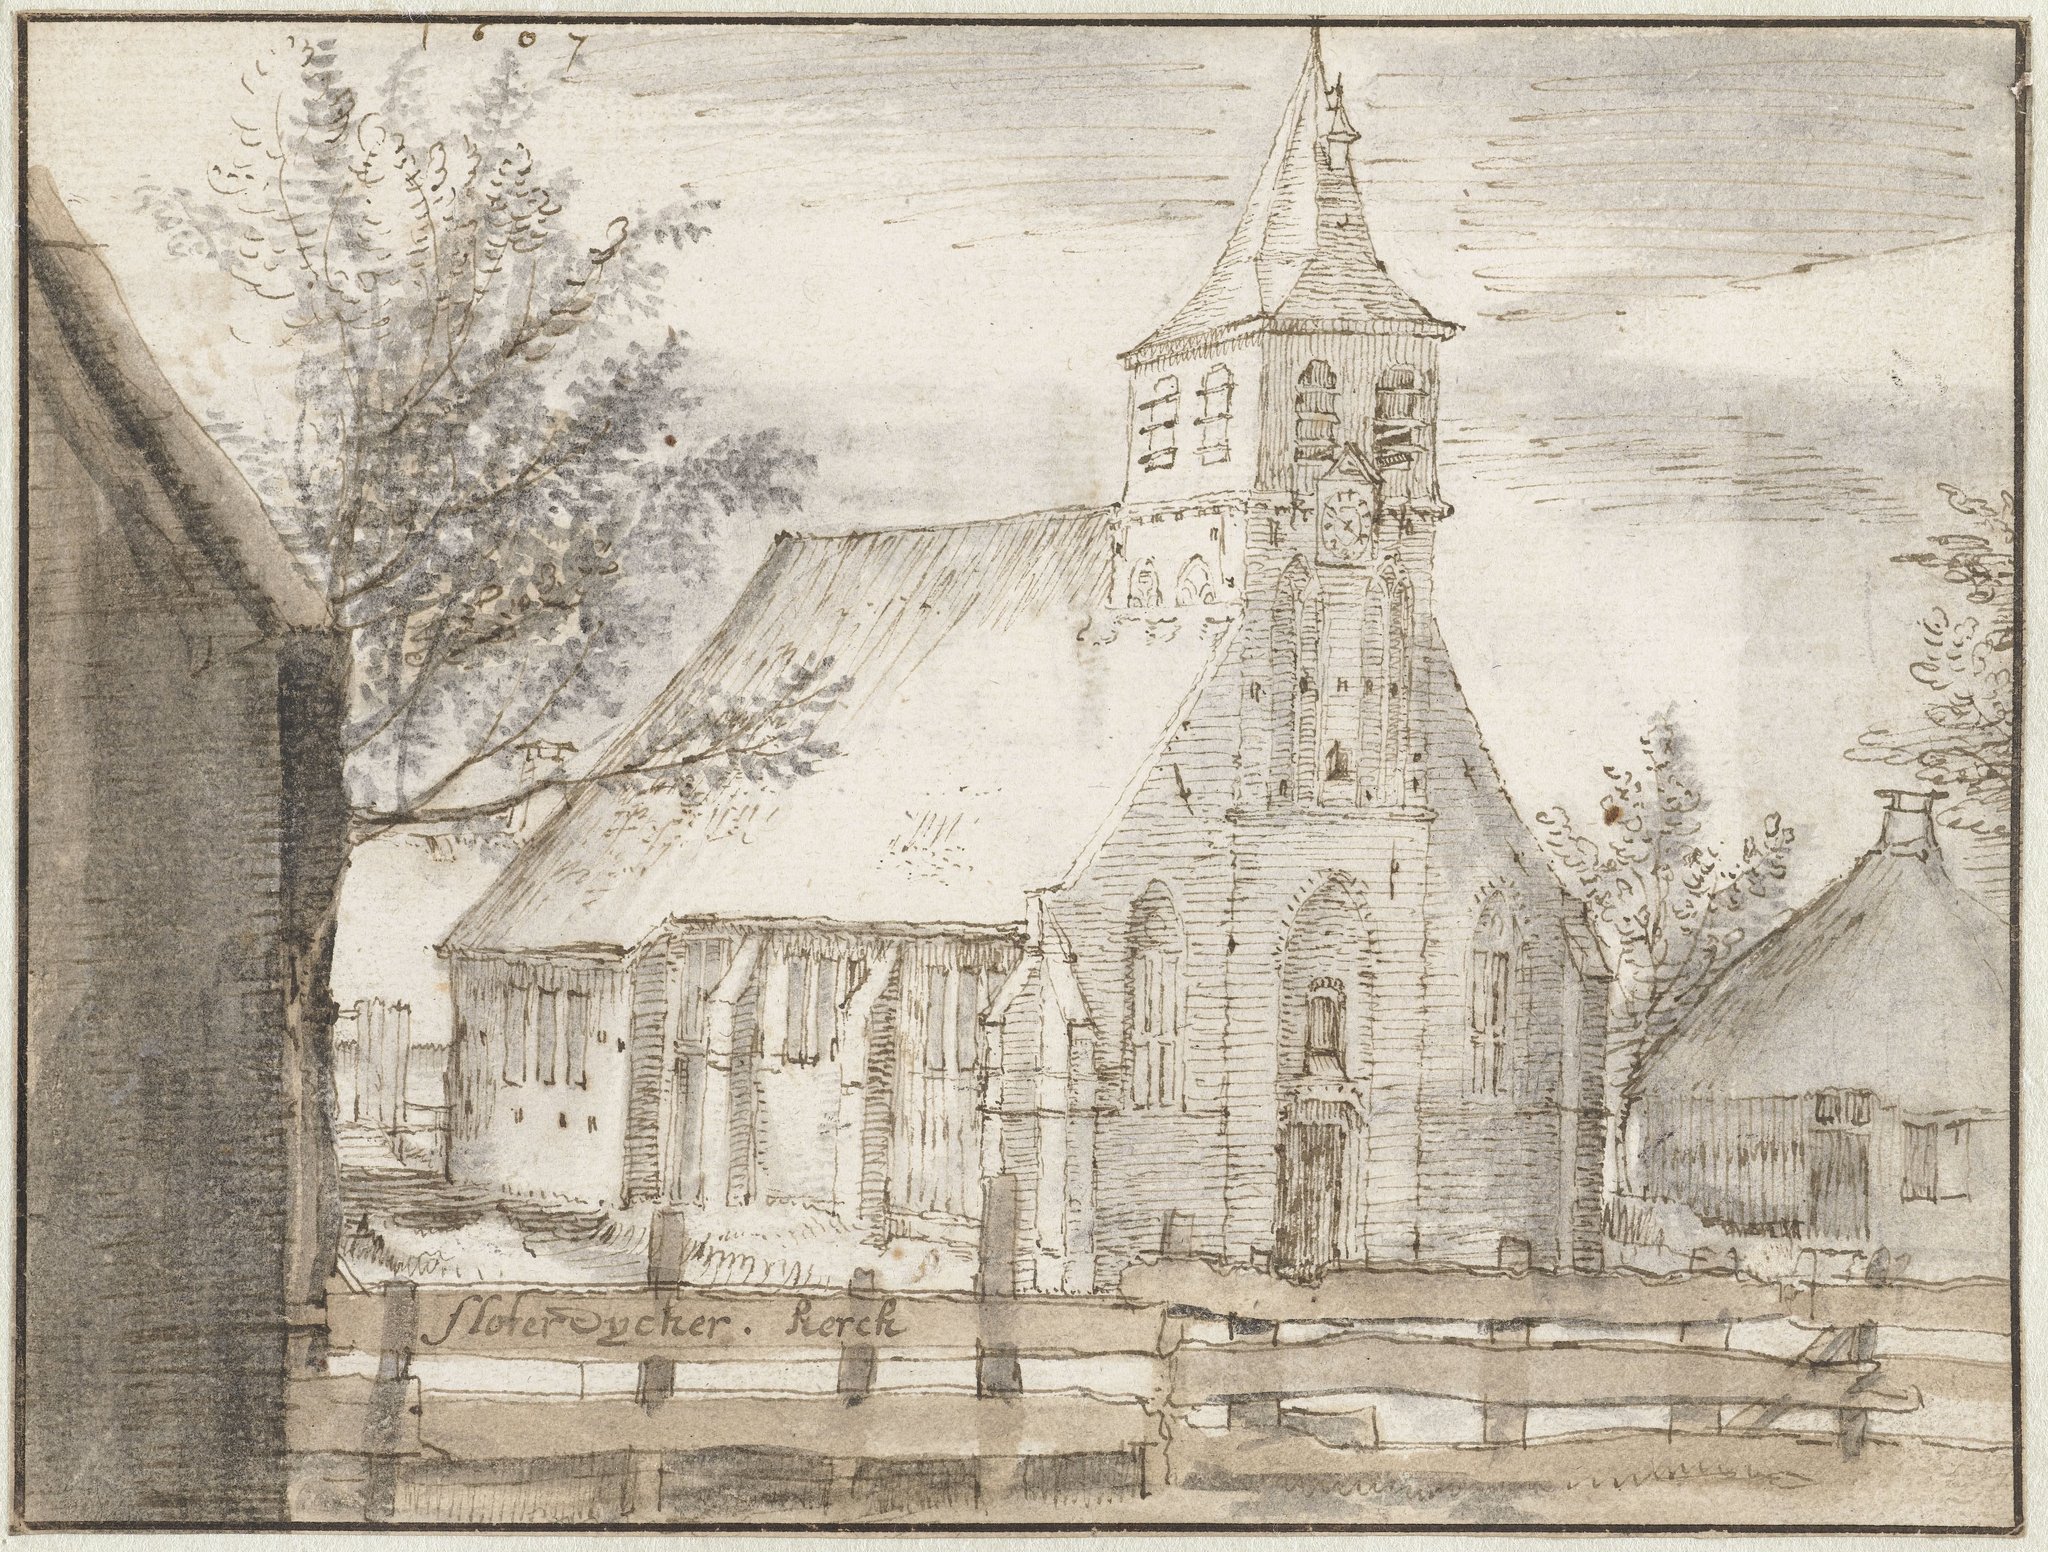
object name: drawing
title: Sloterdycher Kerch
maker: claes jansz. visscher (ii)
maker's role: draughtsman, print maker, publisher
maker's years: 1586-1652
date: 1607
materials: ink, paper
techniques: brush, pen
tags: church (exterior), sloterdijk